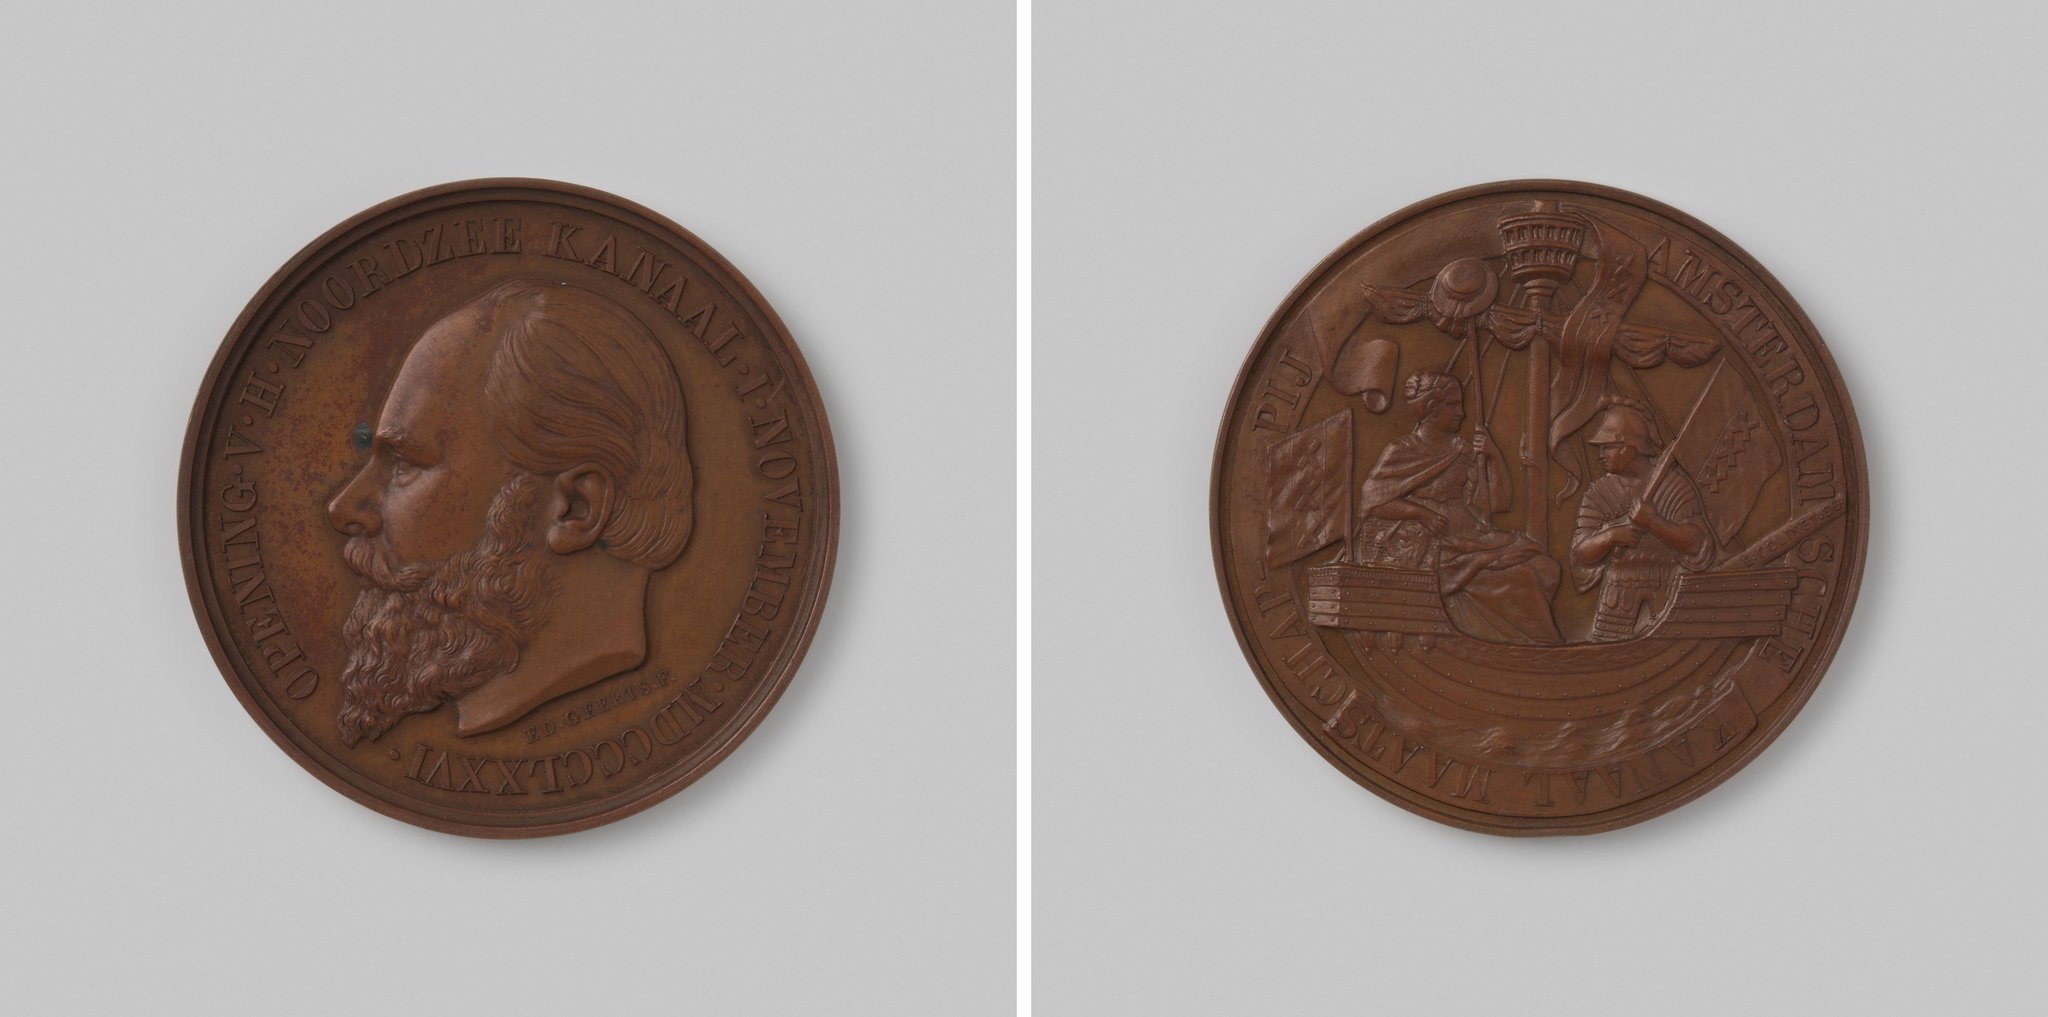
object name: history medal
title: Opening van het Noordzeekanaal 1876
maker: edouard louis geerts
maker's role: medailleur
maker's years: 1846-1889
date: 1876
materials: bronze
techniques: striking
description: Bronzen penning, op de voorzijde het portret van Koning Willem III naar links met omschrift, op de keerzijde een koggeschip waarin de Nederlandse Maagd met speer met vrijheidshoed en een antiek soldaat met de Amsterdamse vlag , met het omschrift op een banderol.